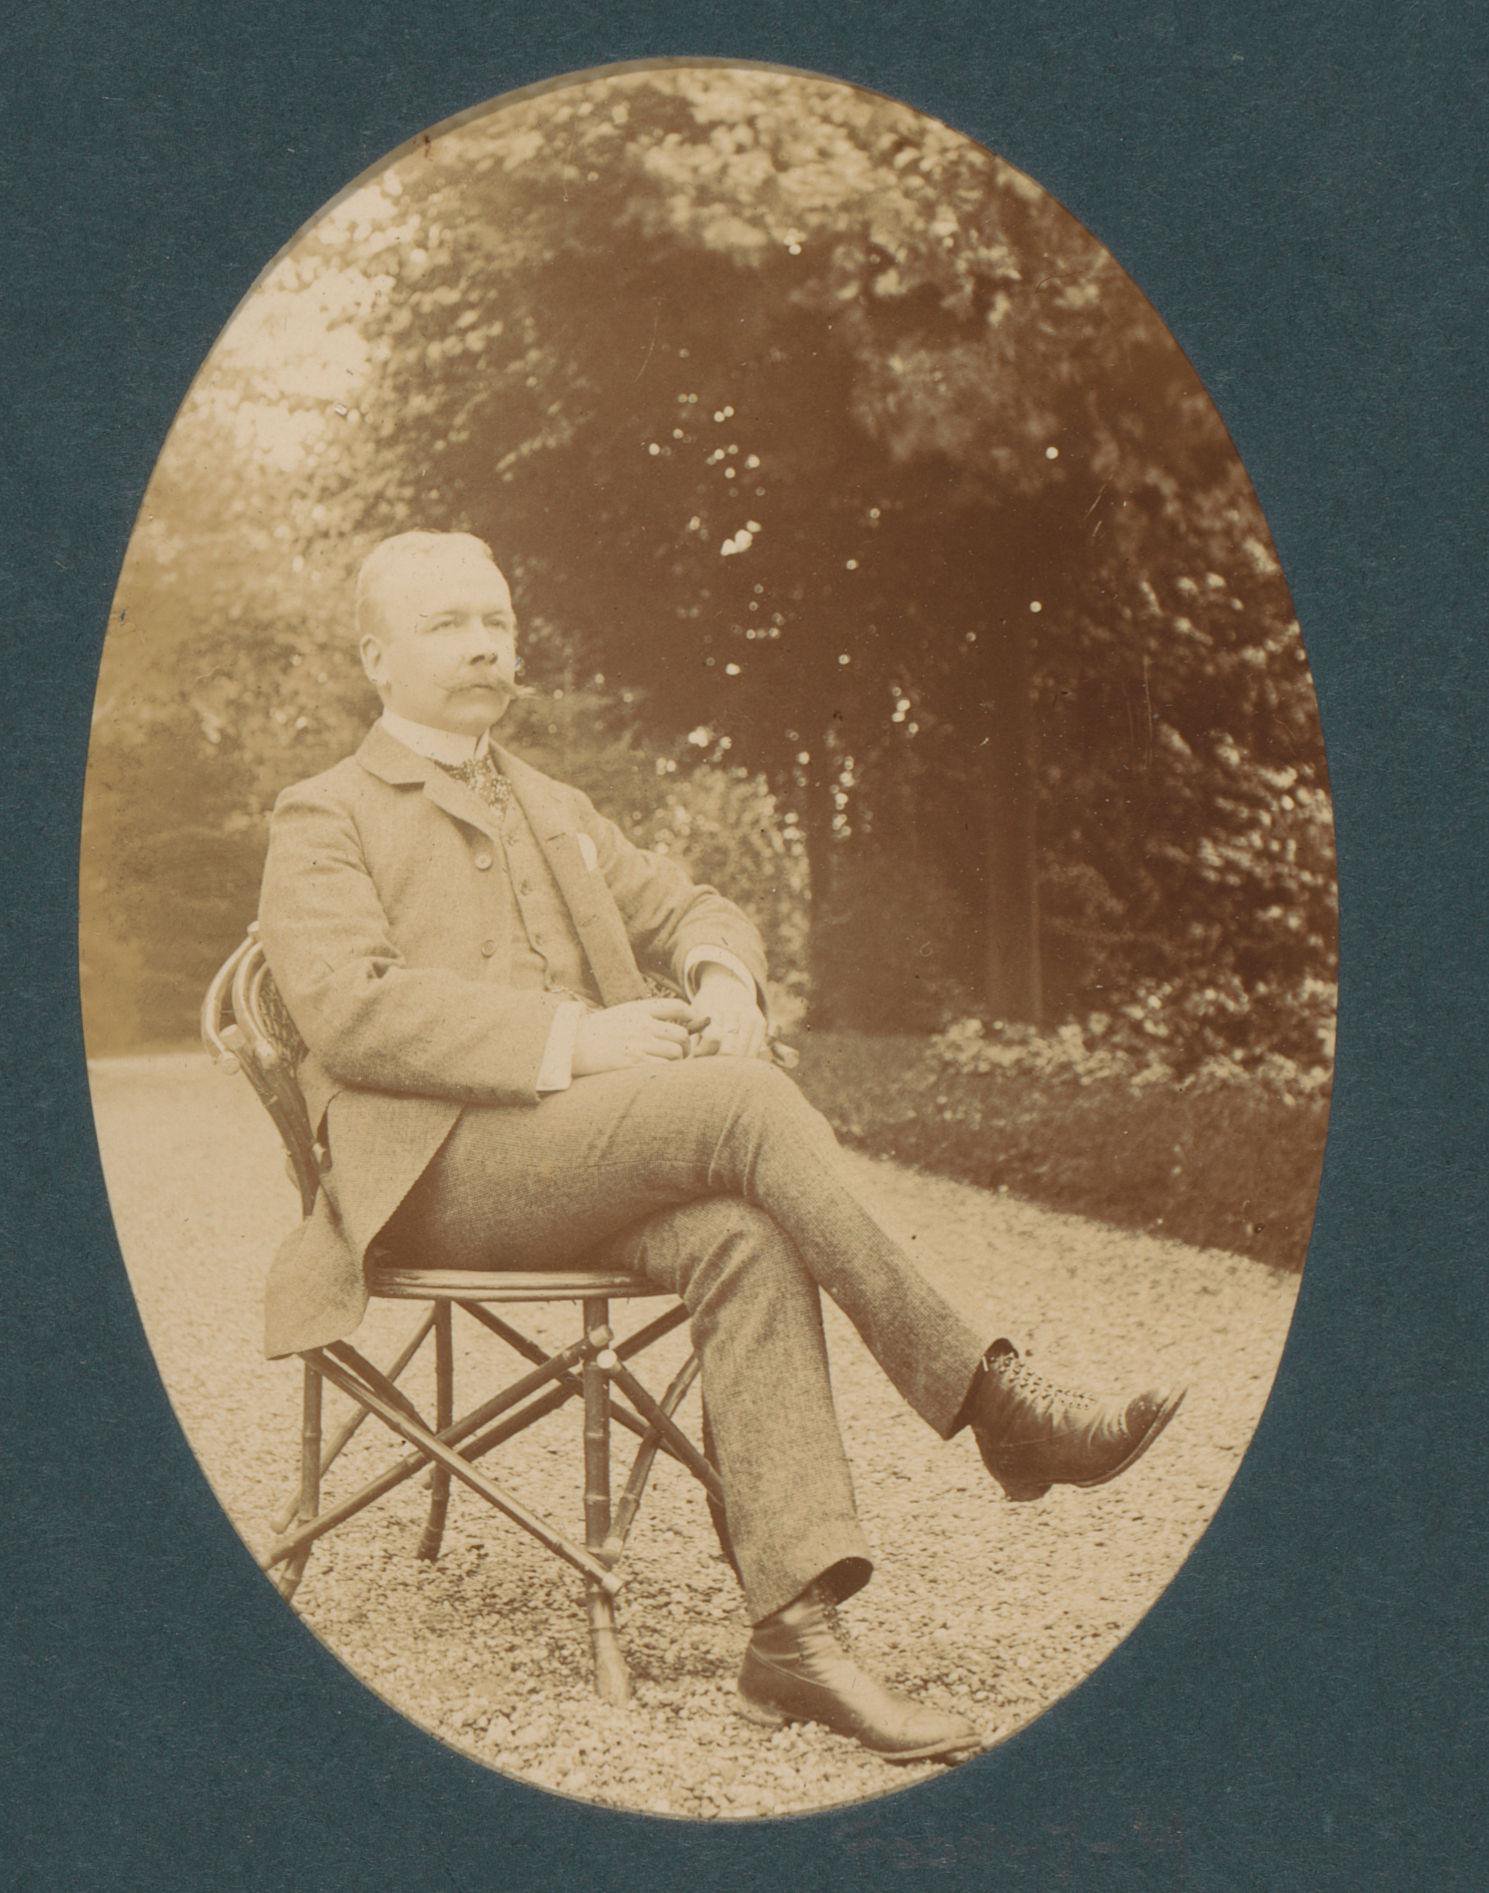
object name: album leaf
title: Portret van een man, zittend in de buitenlucht, vermoedelijk in Nederland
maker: Anonymous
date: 1902-1906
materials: cardboard, paper, photographic support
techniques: gelatin silver print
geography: netherlands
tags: adult man, chair, netherlands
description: Onderdeel van Reisalbum van een Nederlandse familie met bezienswaardigheden in Europa, Egypte en New York.